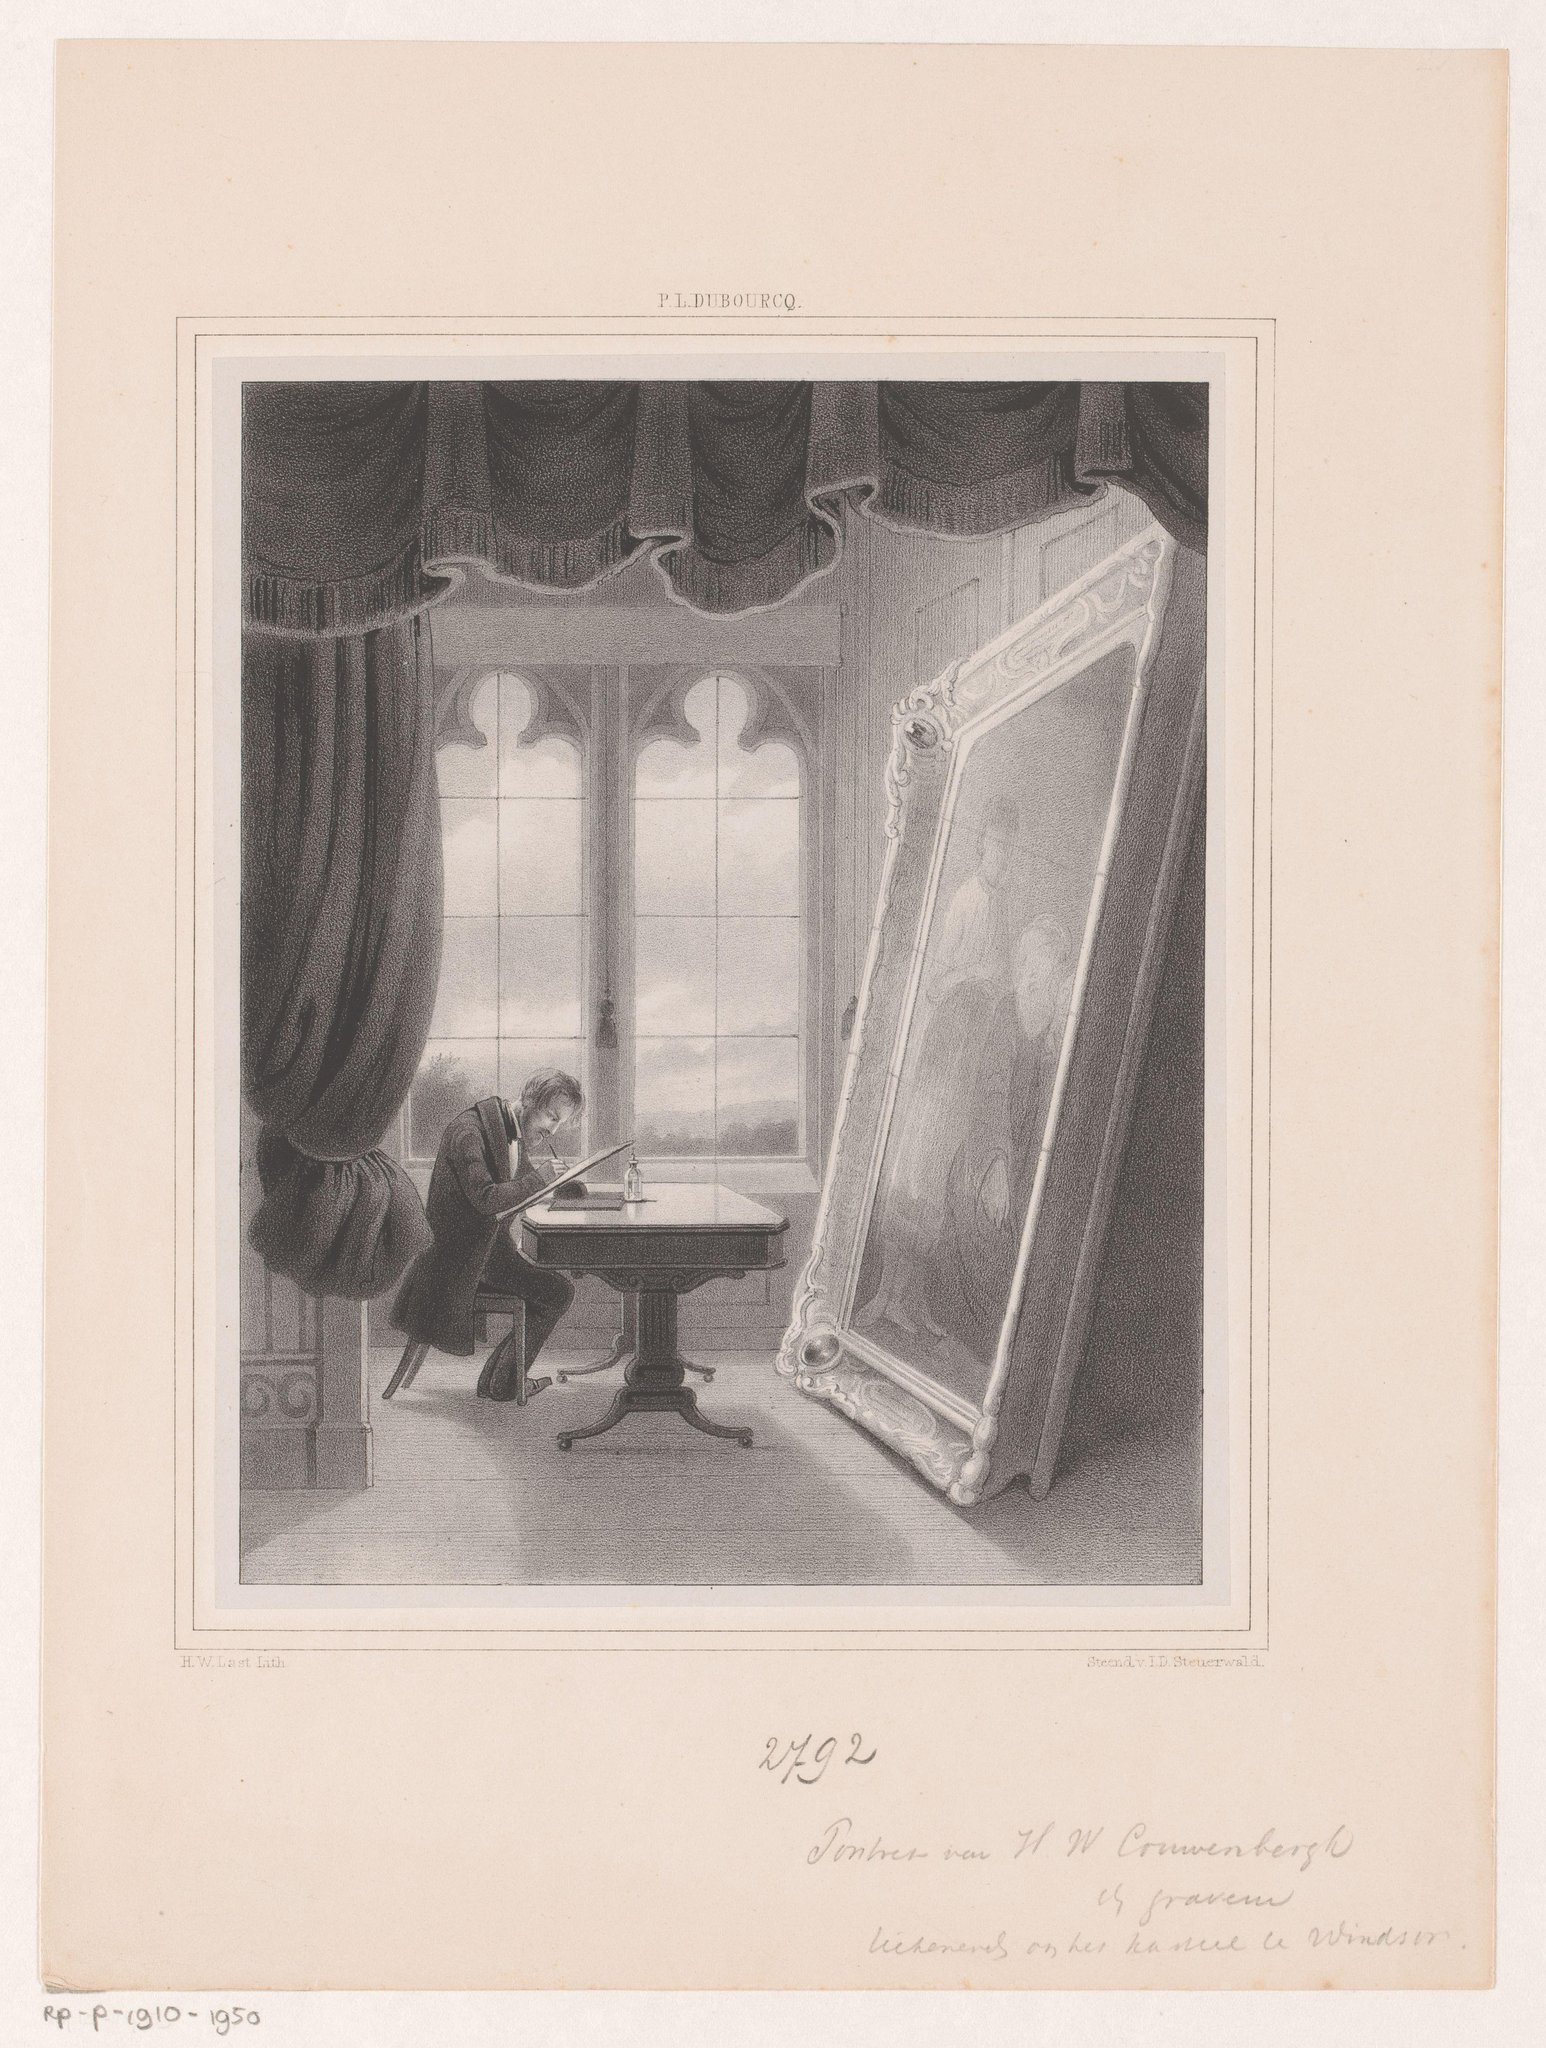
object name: print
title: Henricus Wilhelmus Couwenberg kopieert een schilderij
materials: paper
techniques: lithograph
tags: the hague, amsterdam, print maker, draughtsman, henricus wilhelmus couwenberg, drawing, sketch, picture within picture, artist (in general) making preliminary designs, sketching, picture, painting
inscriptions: collector's mark: Lugt 2228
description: De graveur Henricus Wilhelmus Couwenberg bezig op het kasteel te Windsor met het kopiëren van het schilderij 'Mignon en de oude harpenaar' van Ary Scheffer uit 1844.